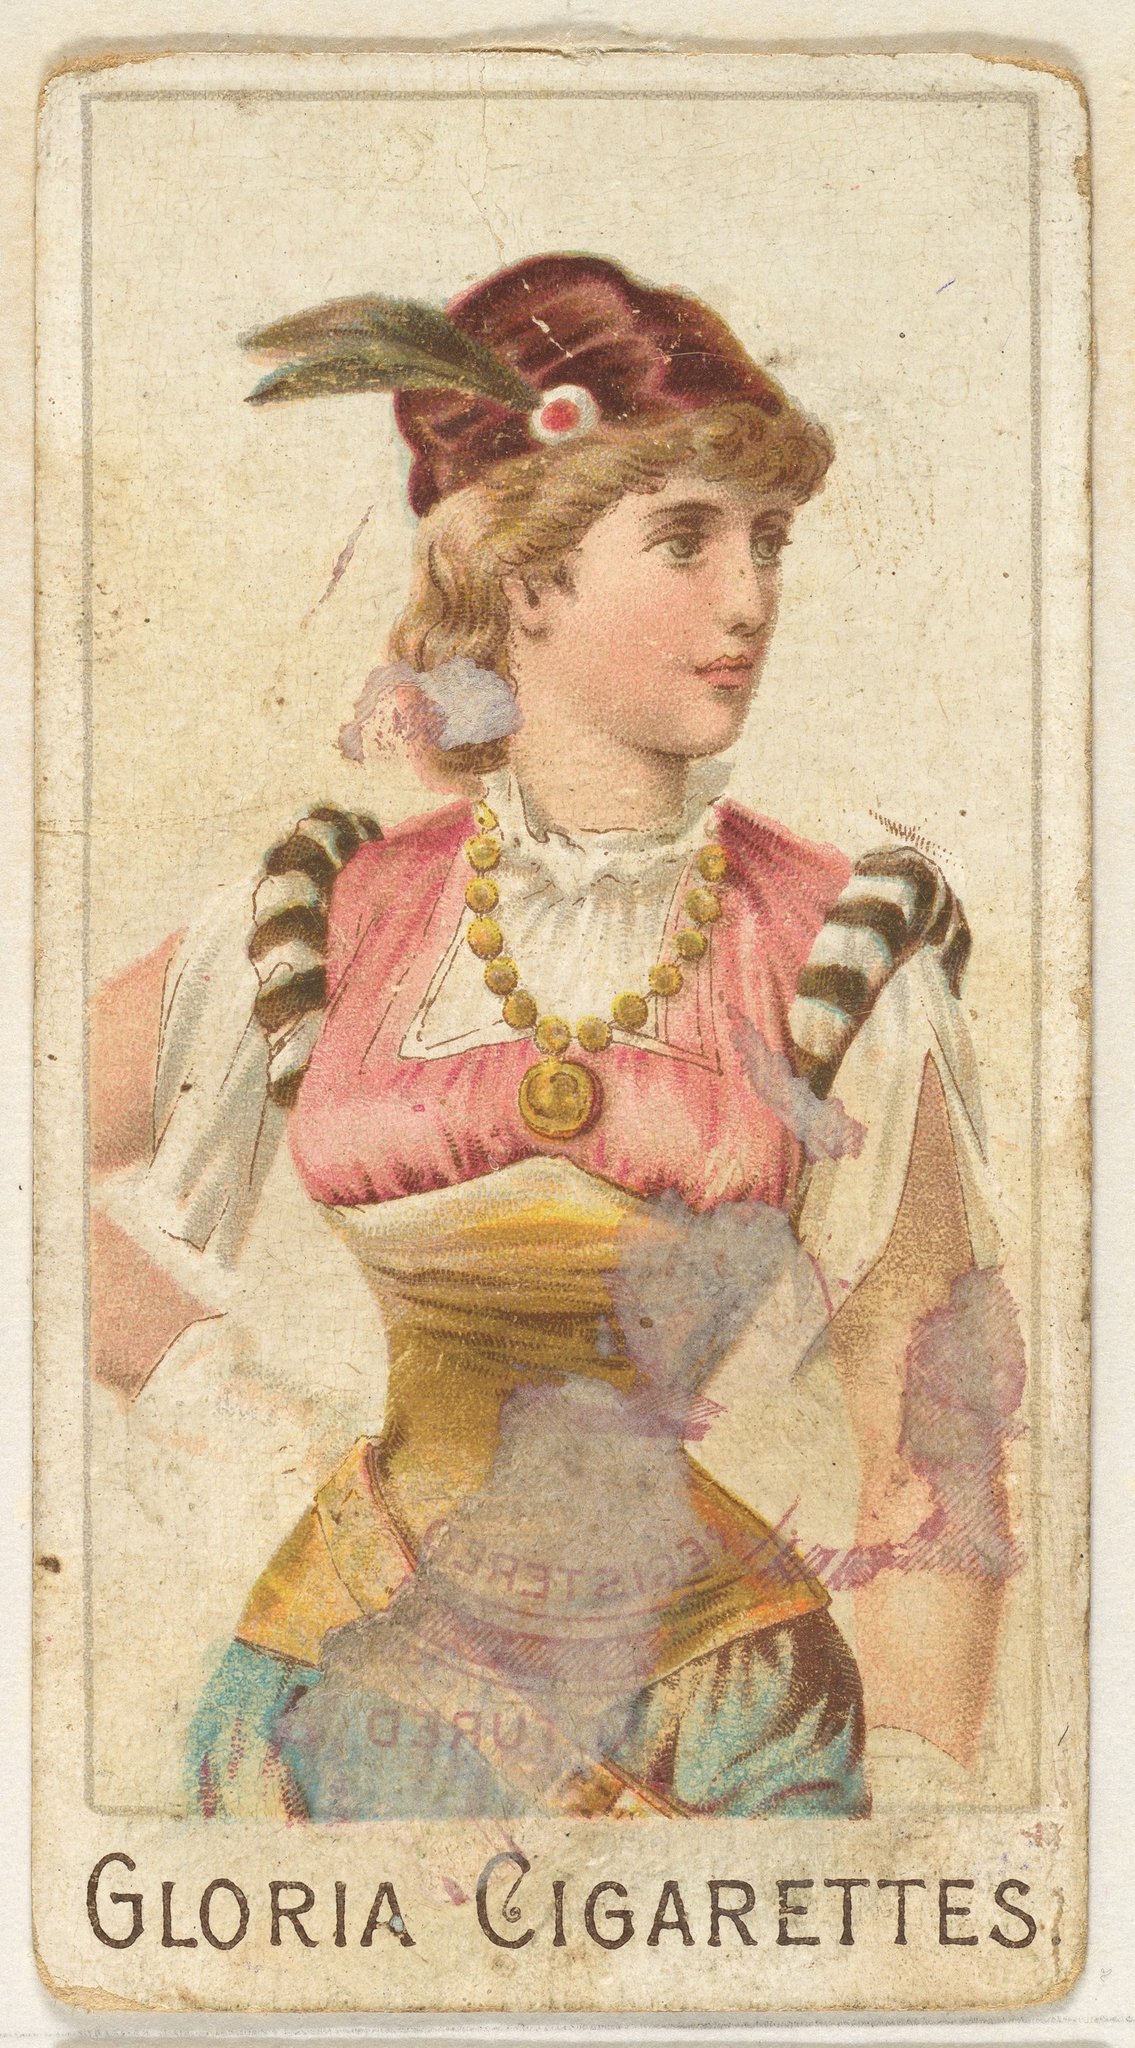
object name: print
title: From the series "Sports Girls" (C190), issued by the American Cigarette Company, Ltd., Montreal, to promote Gloria Cigarettes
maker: american cigarette company, ltd.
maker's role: publisher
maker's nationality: canadian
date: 1889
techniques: color lithograph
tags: women